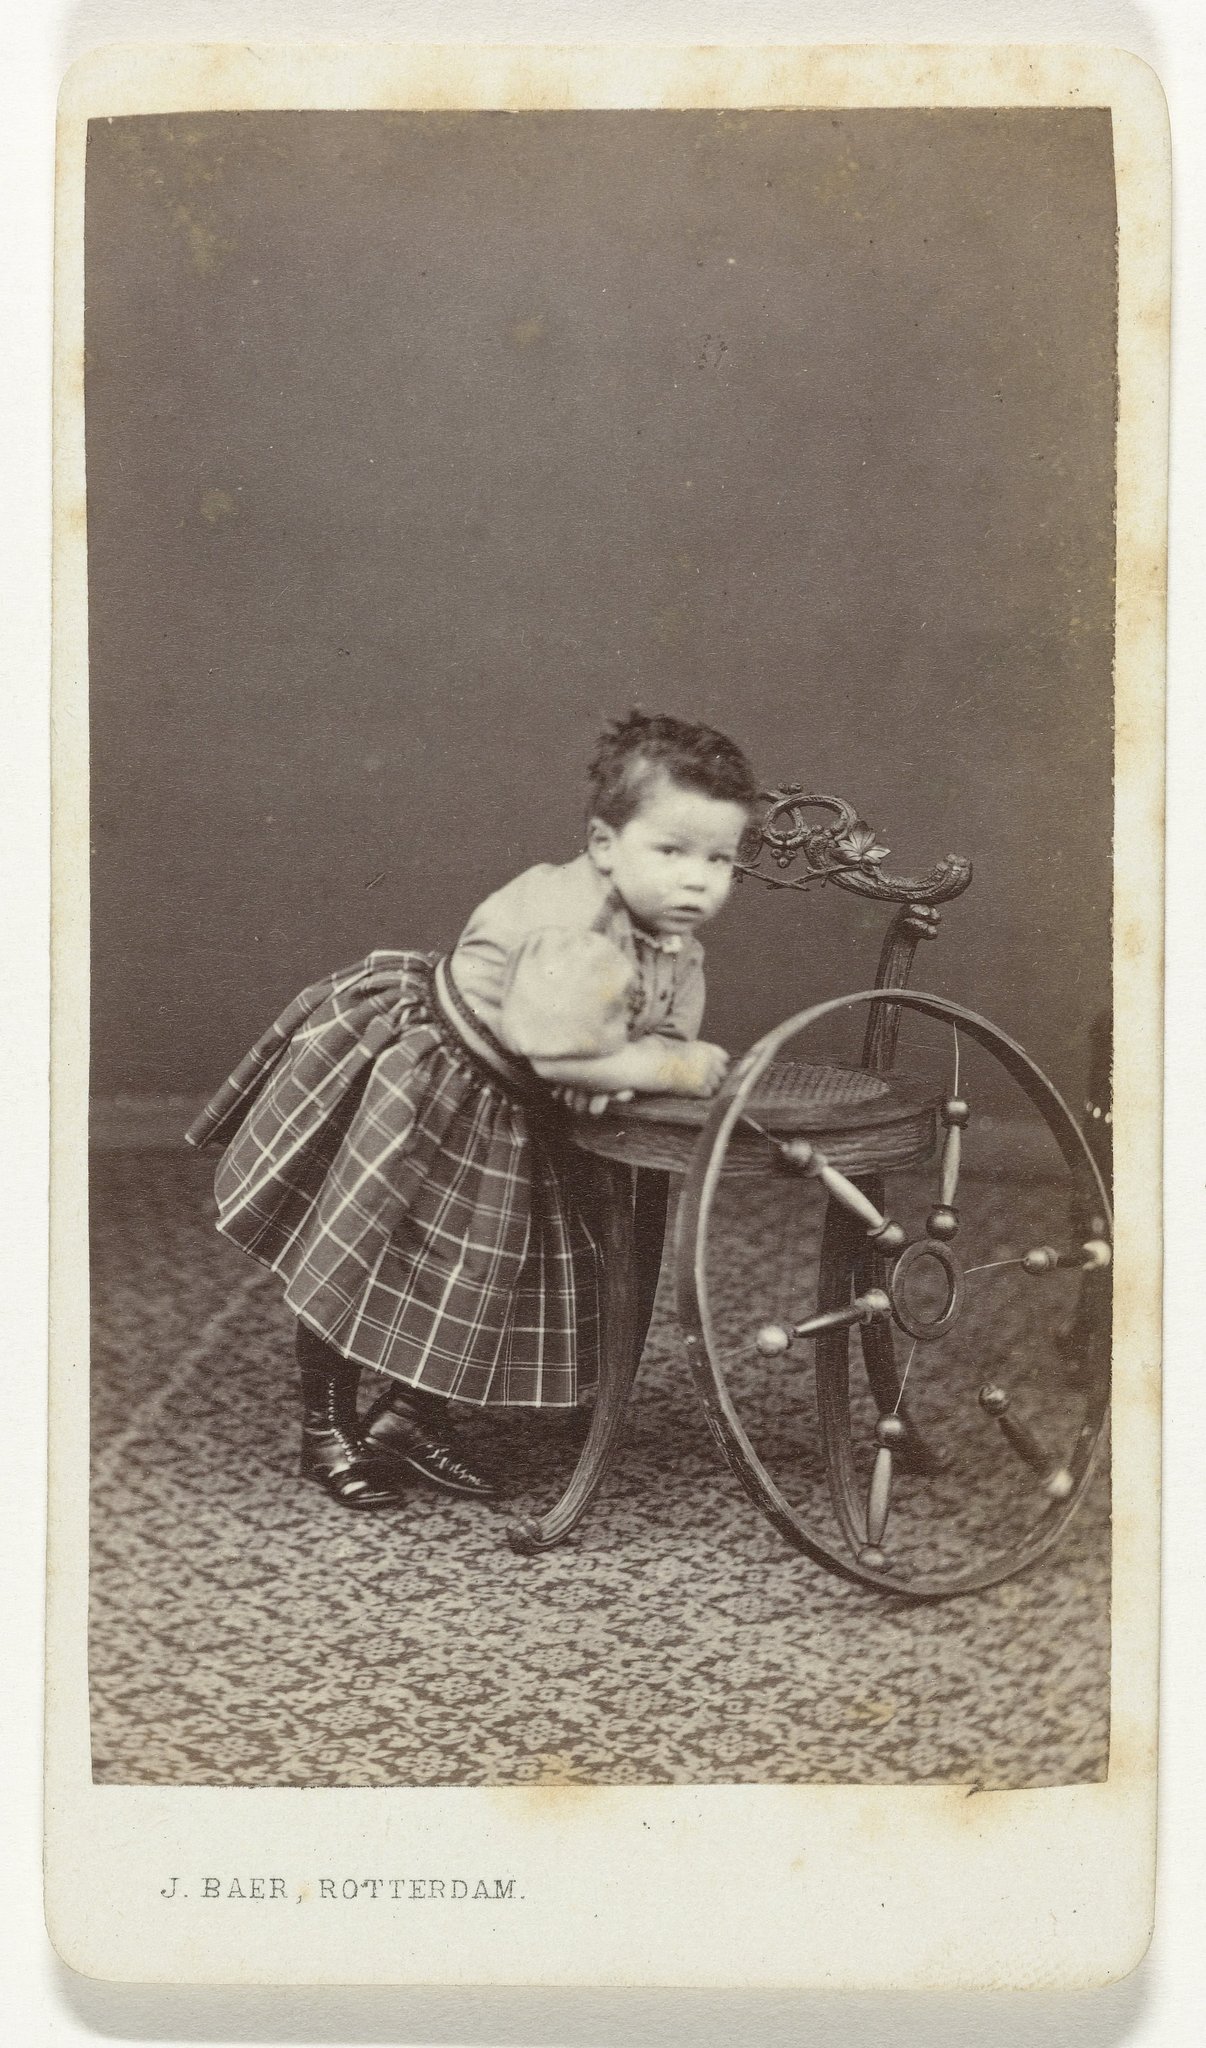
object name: photograph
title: Portret van een klein kind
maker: johannes baer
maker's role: fotograaf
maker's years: 1840-1912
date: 1860-1865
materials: cardboard, paper, photographic support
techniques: albumen print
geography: rotterdam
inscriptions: address: ‘J. Baer/Photographe/Rotterdam’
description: Een klein kind in een geruite rok, leunend tegen een stoel waartegen een hoepel staat.